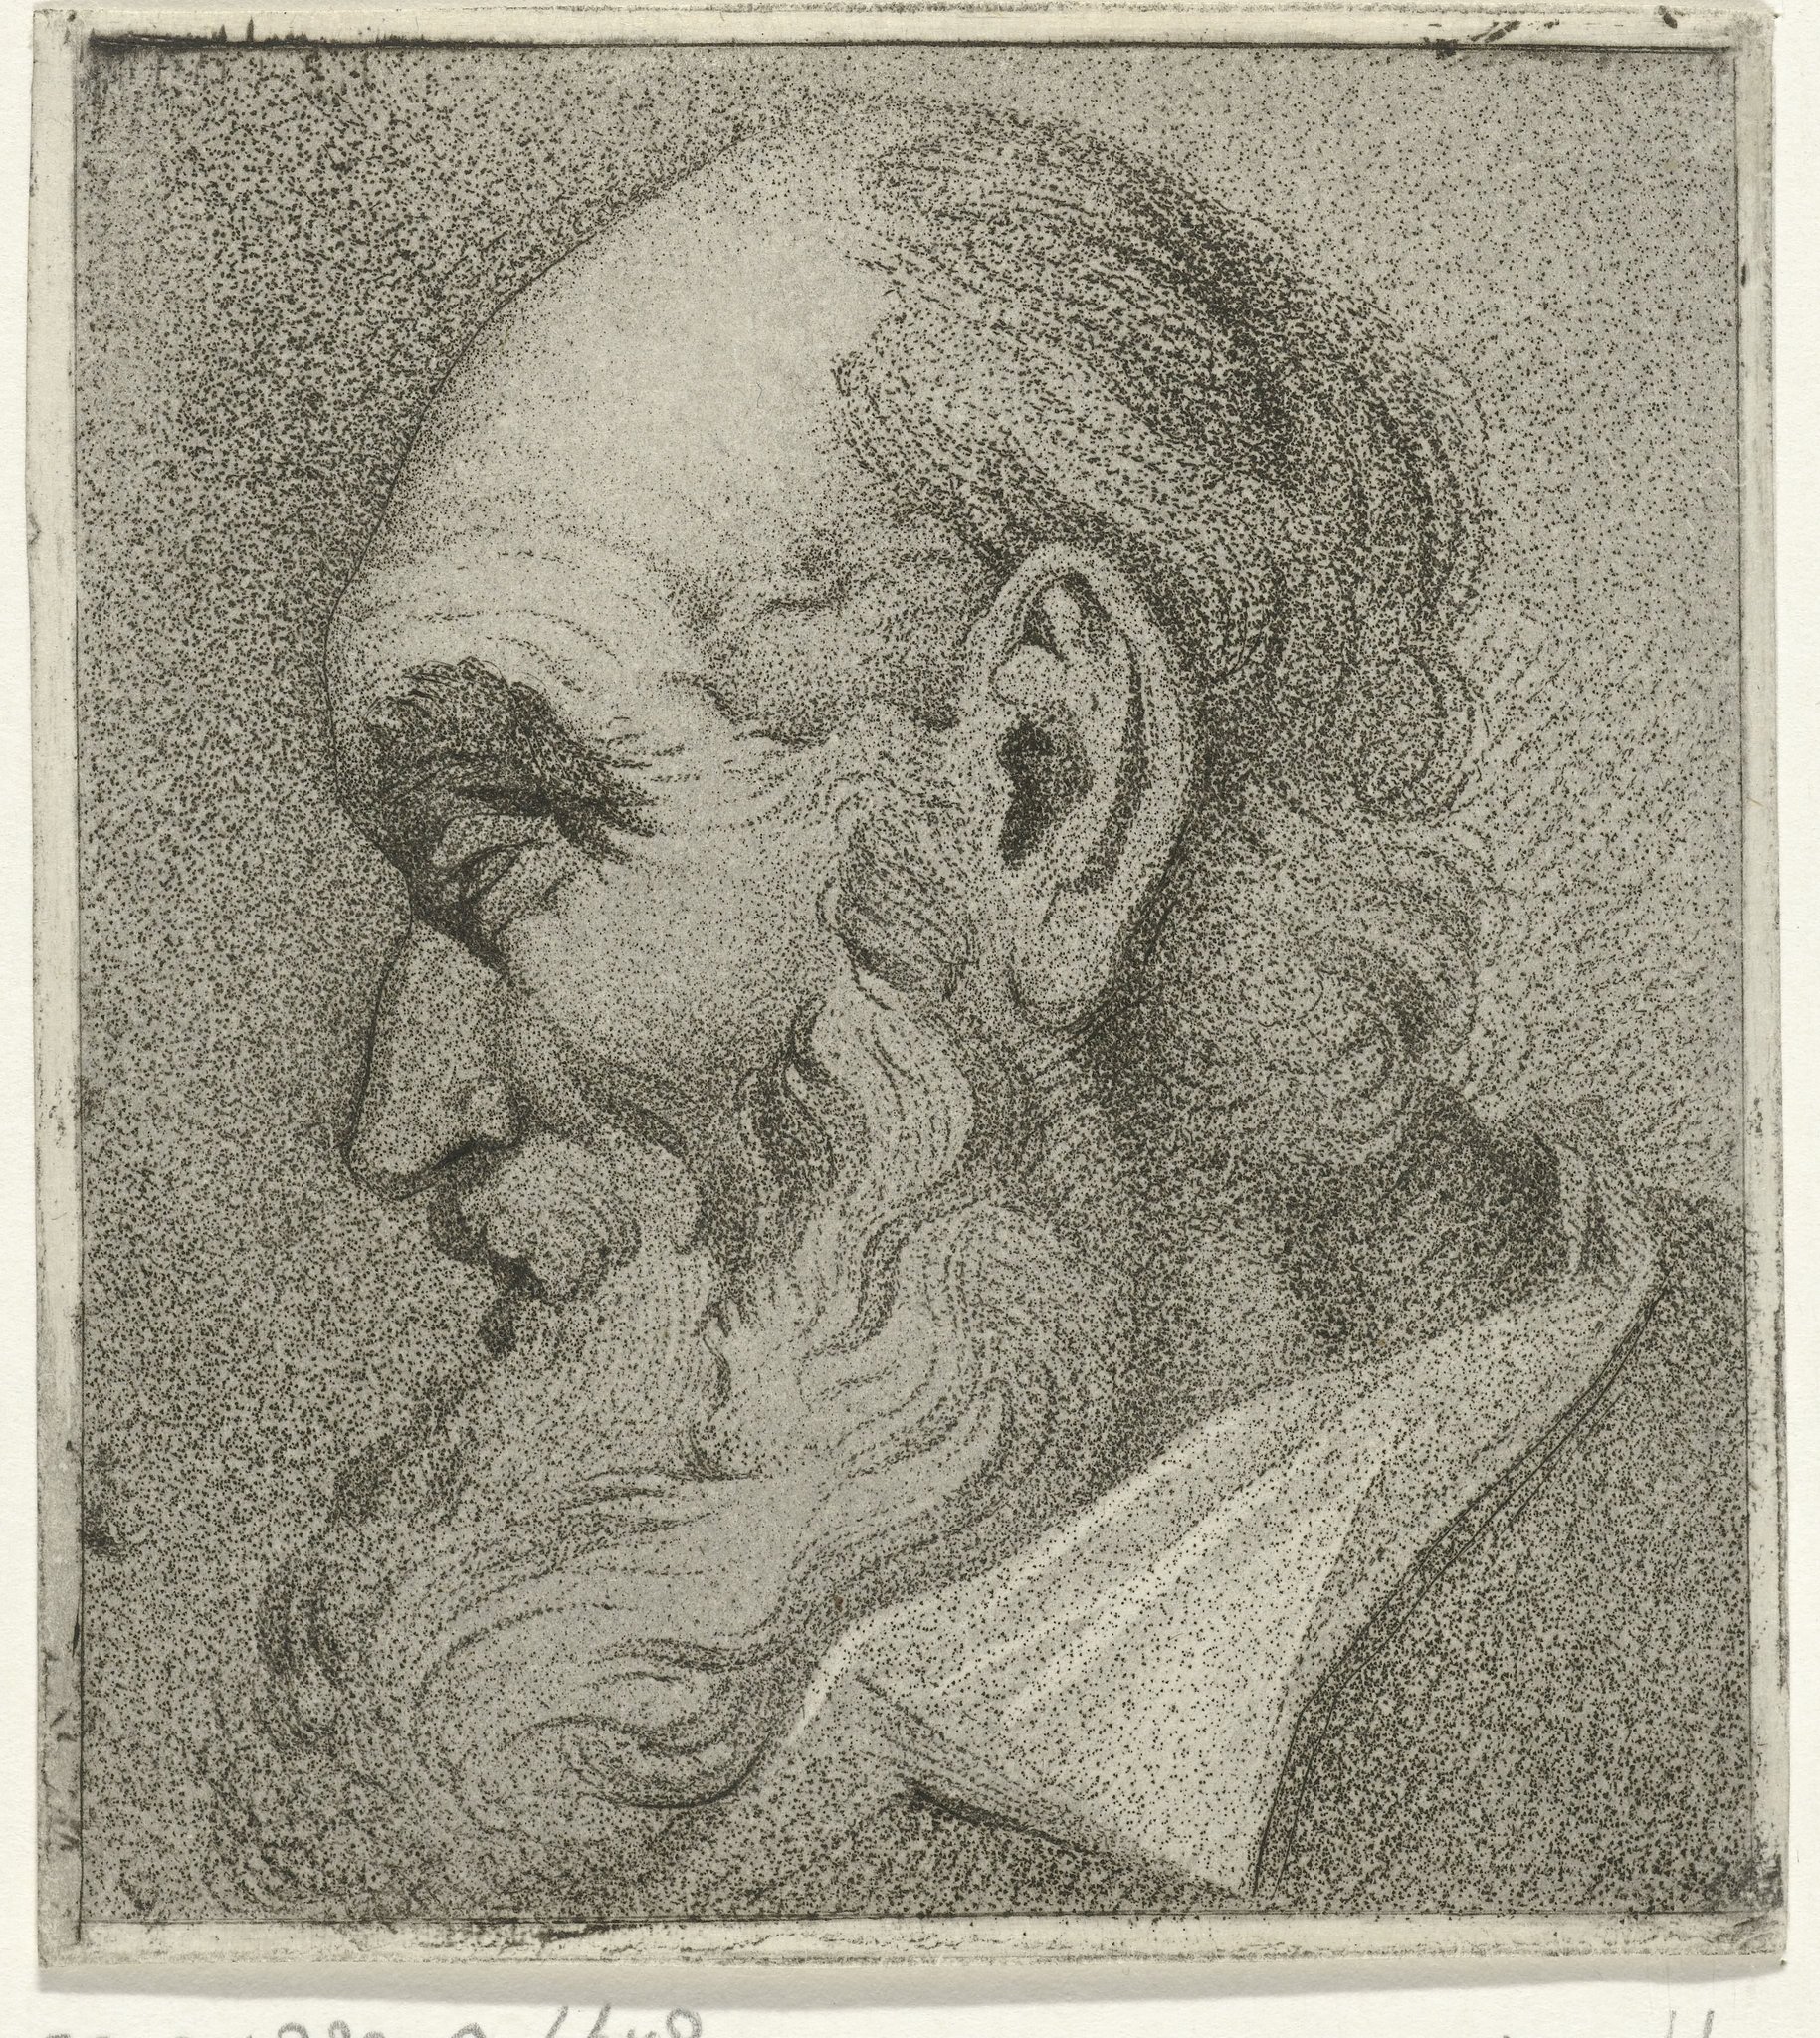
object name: print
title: Portret van een grijsaard, en profil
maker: hermanus fock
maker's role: conservator, draughtsman, painter, print maker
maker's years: 1766-1822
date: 1781-1822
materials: paper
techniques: printmaking, etching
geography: amsterdam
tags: old man